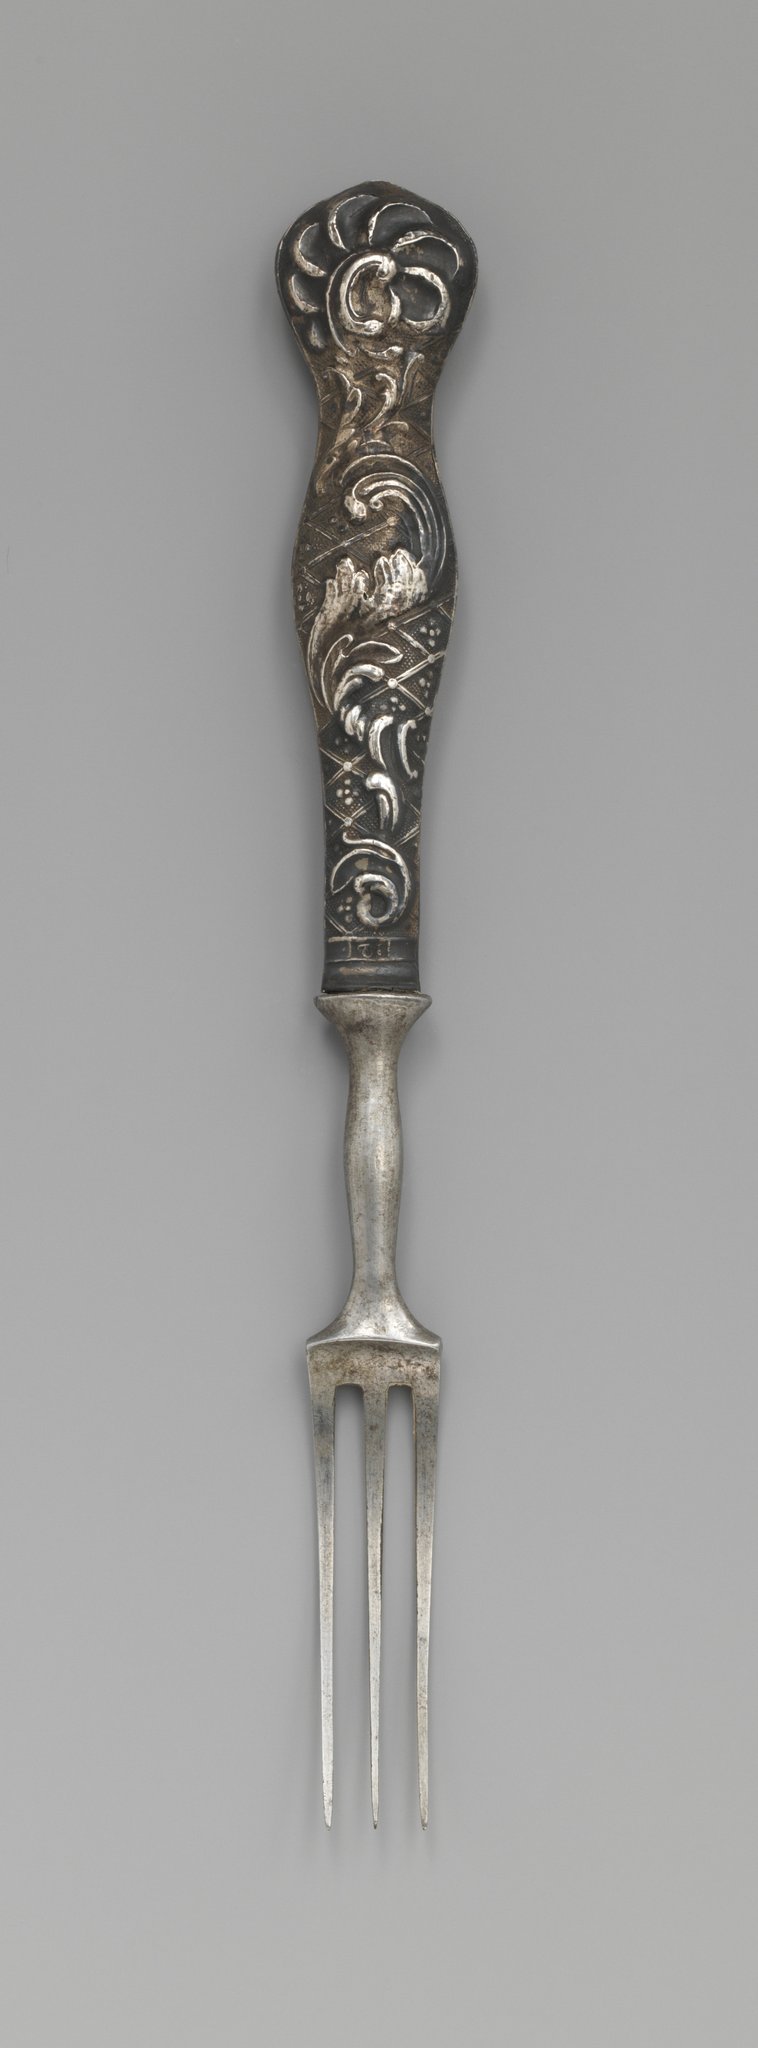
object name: table fork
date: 1812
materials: silver, steel